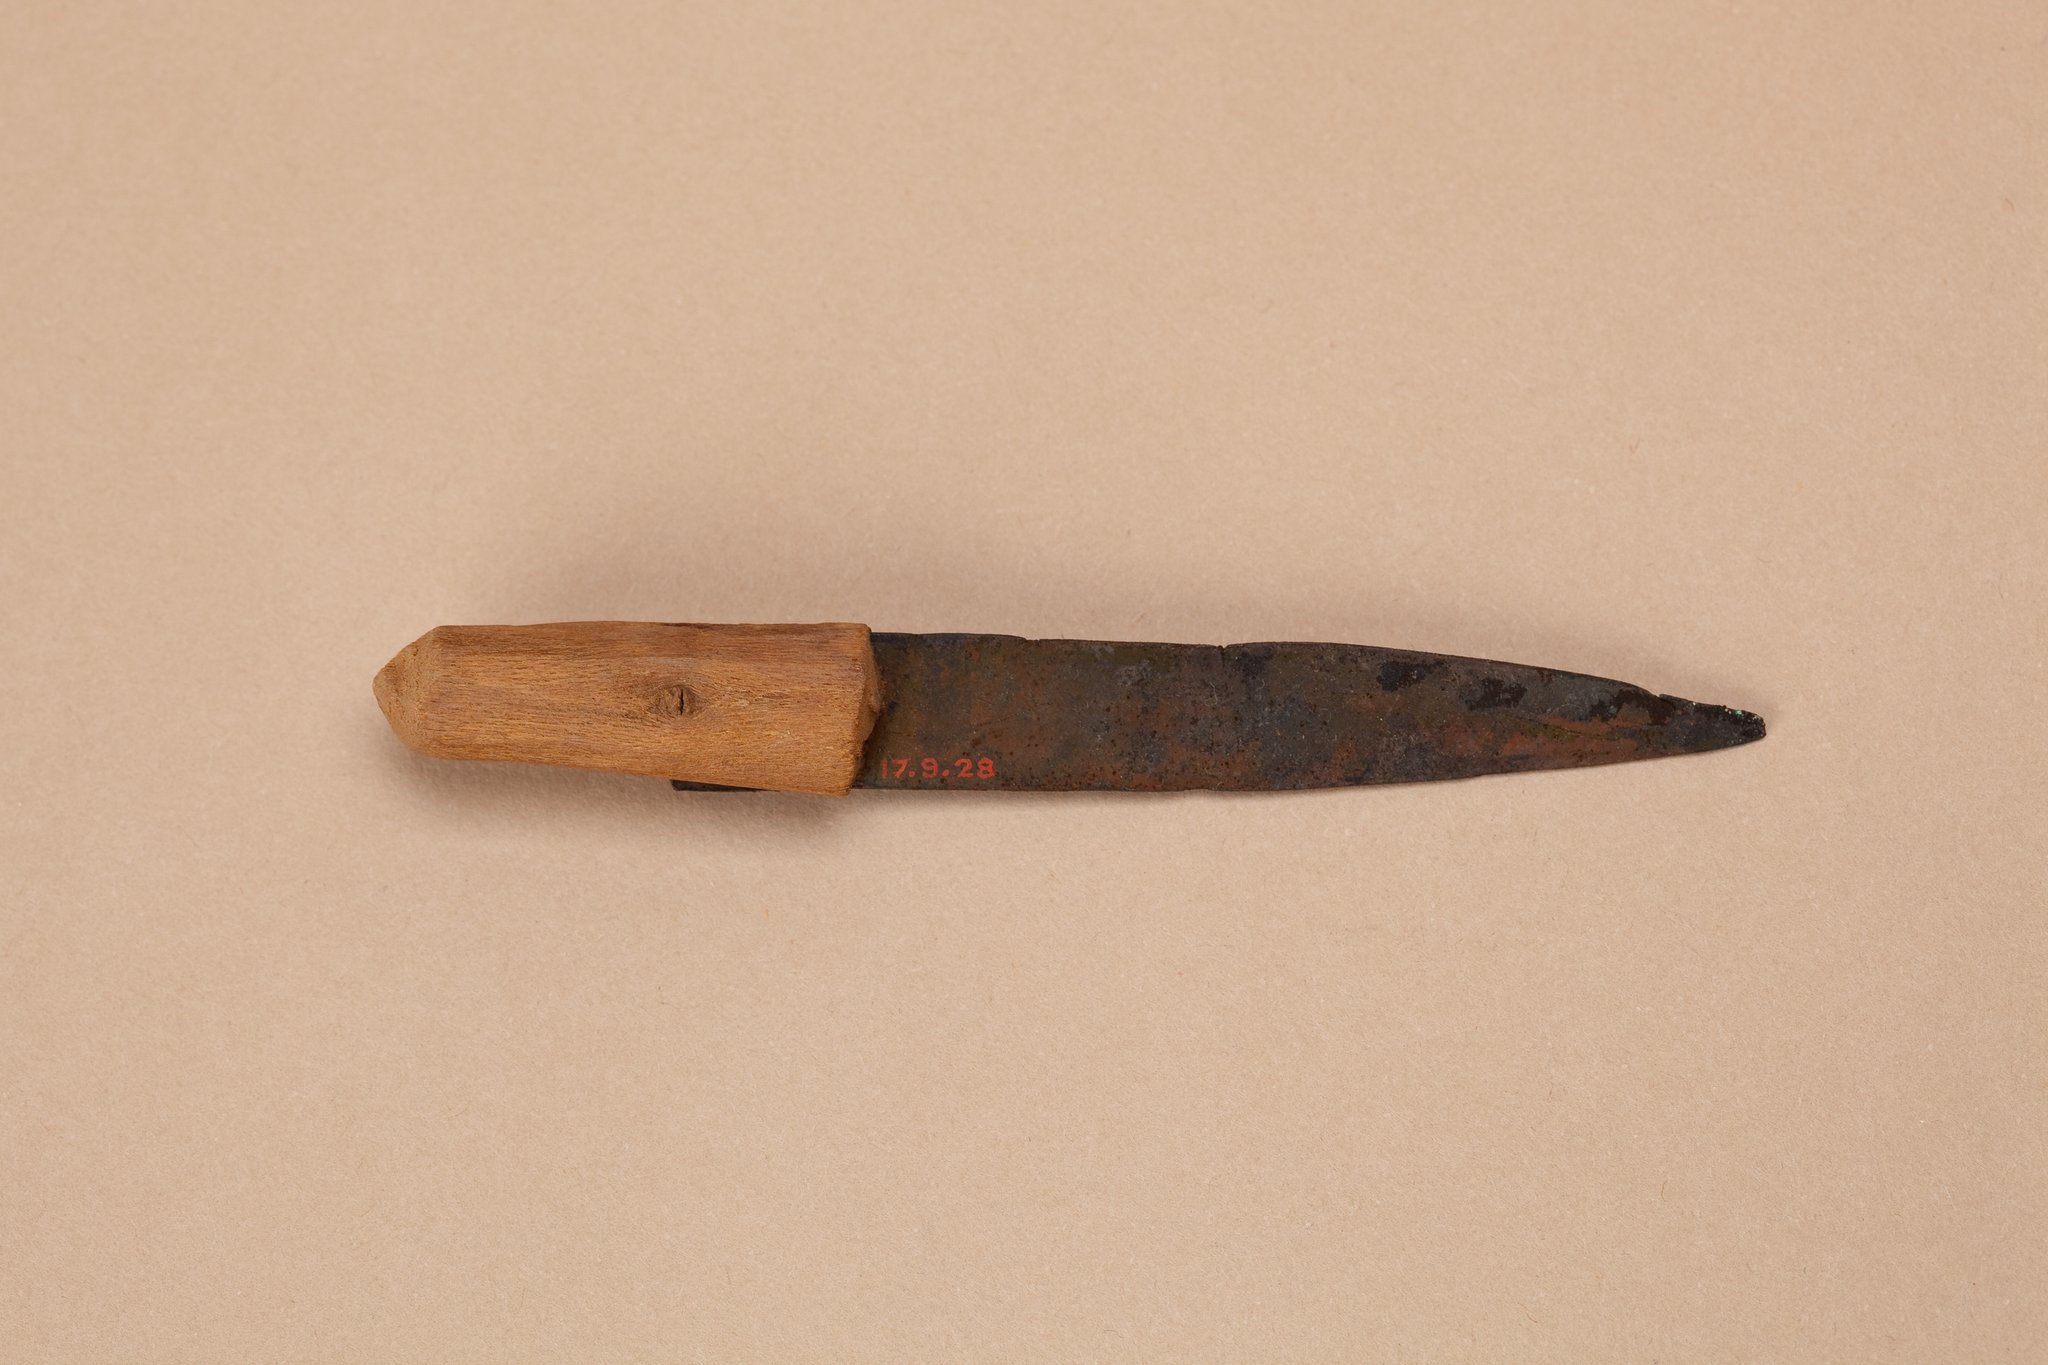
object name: model chisel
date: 1981-1802 BCE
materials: copper, wood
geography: egypt